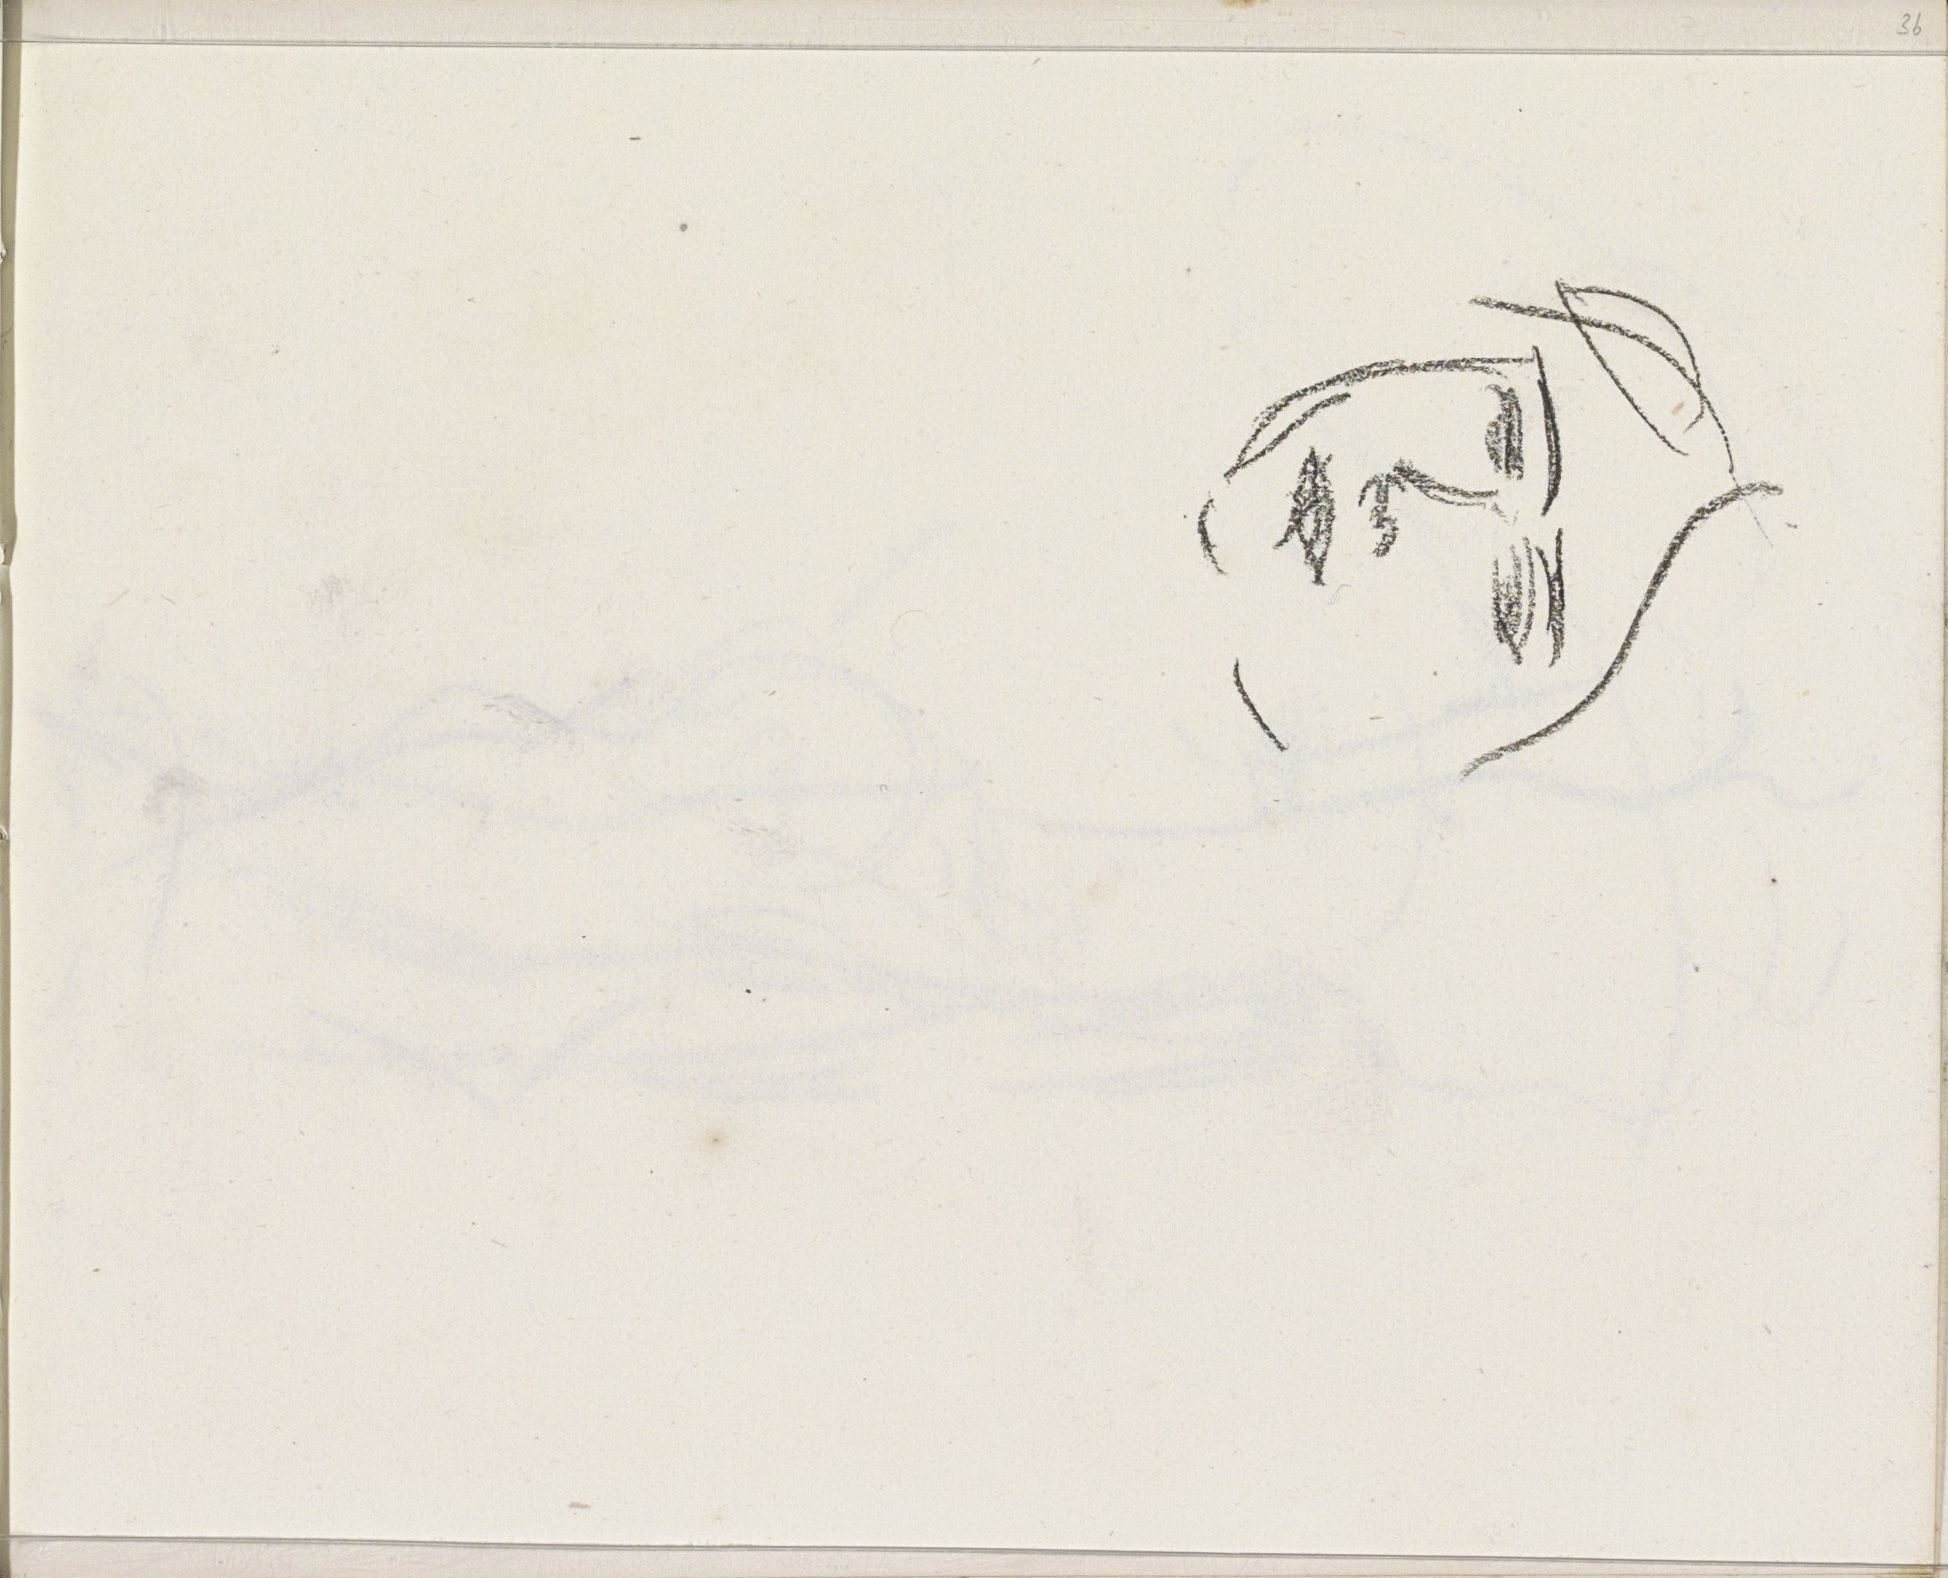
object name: sketchbook leaf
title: Gezicht van een vrouw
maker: isaac israels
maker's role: draughtsman, painter, print maker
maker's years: 1865-1934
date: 1875-1934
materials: chalk, paper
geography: the hague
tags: face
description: Pagina 36 uit schetsboek XLIII met 61 pagina's.